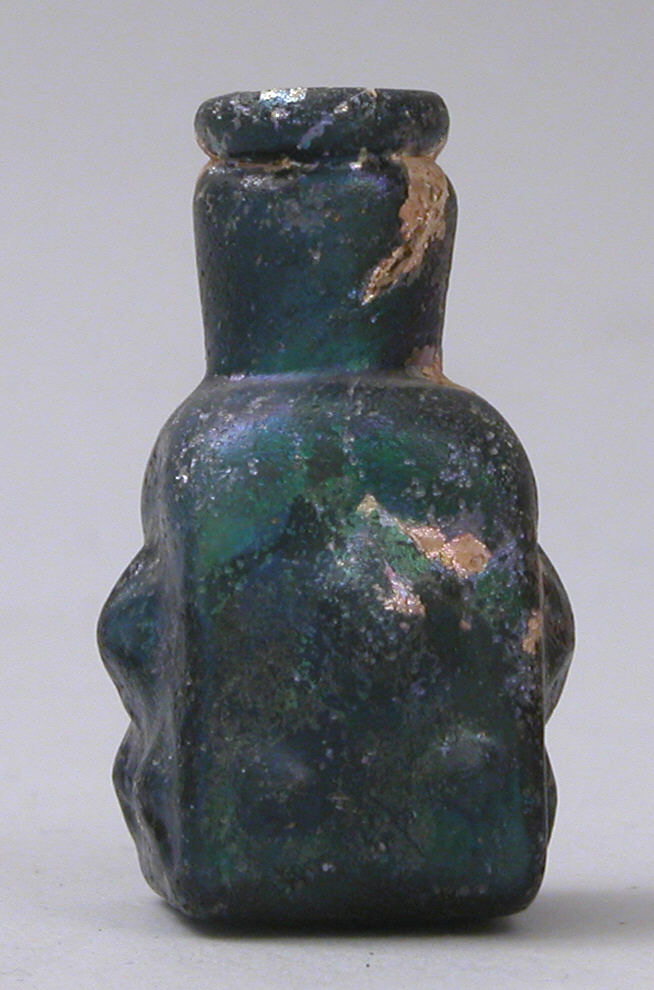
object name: flask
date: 601-800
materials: glass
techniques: glassblowing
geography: iraq